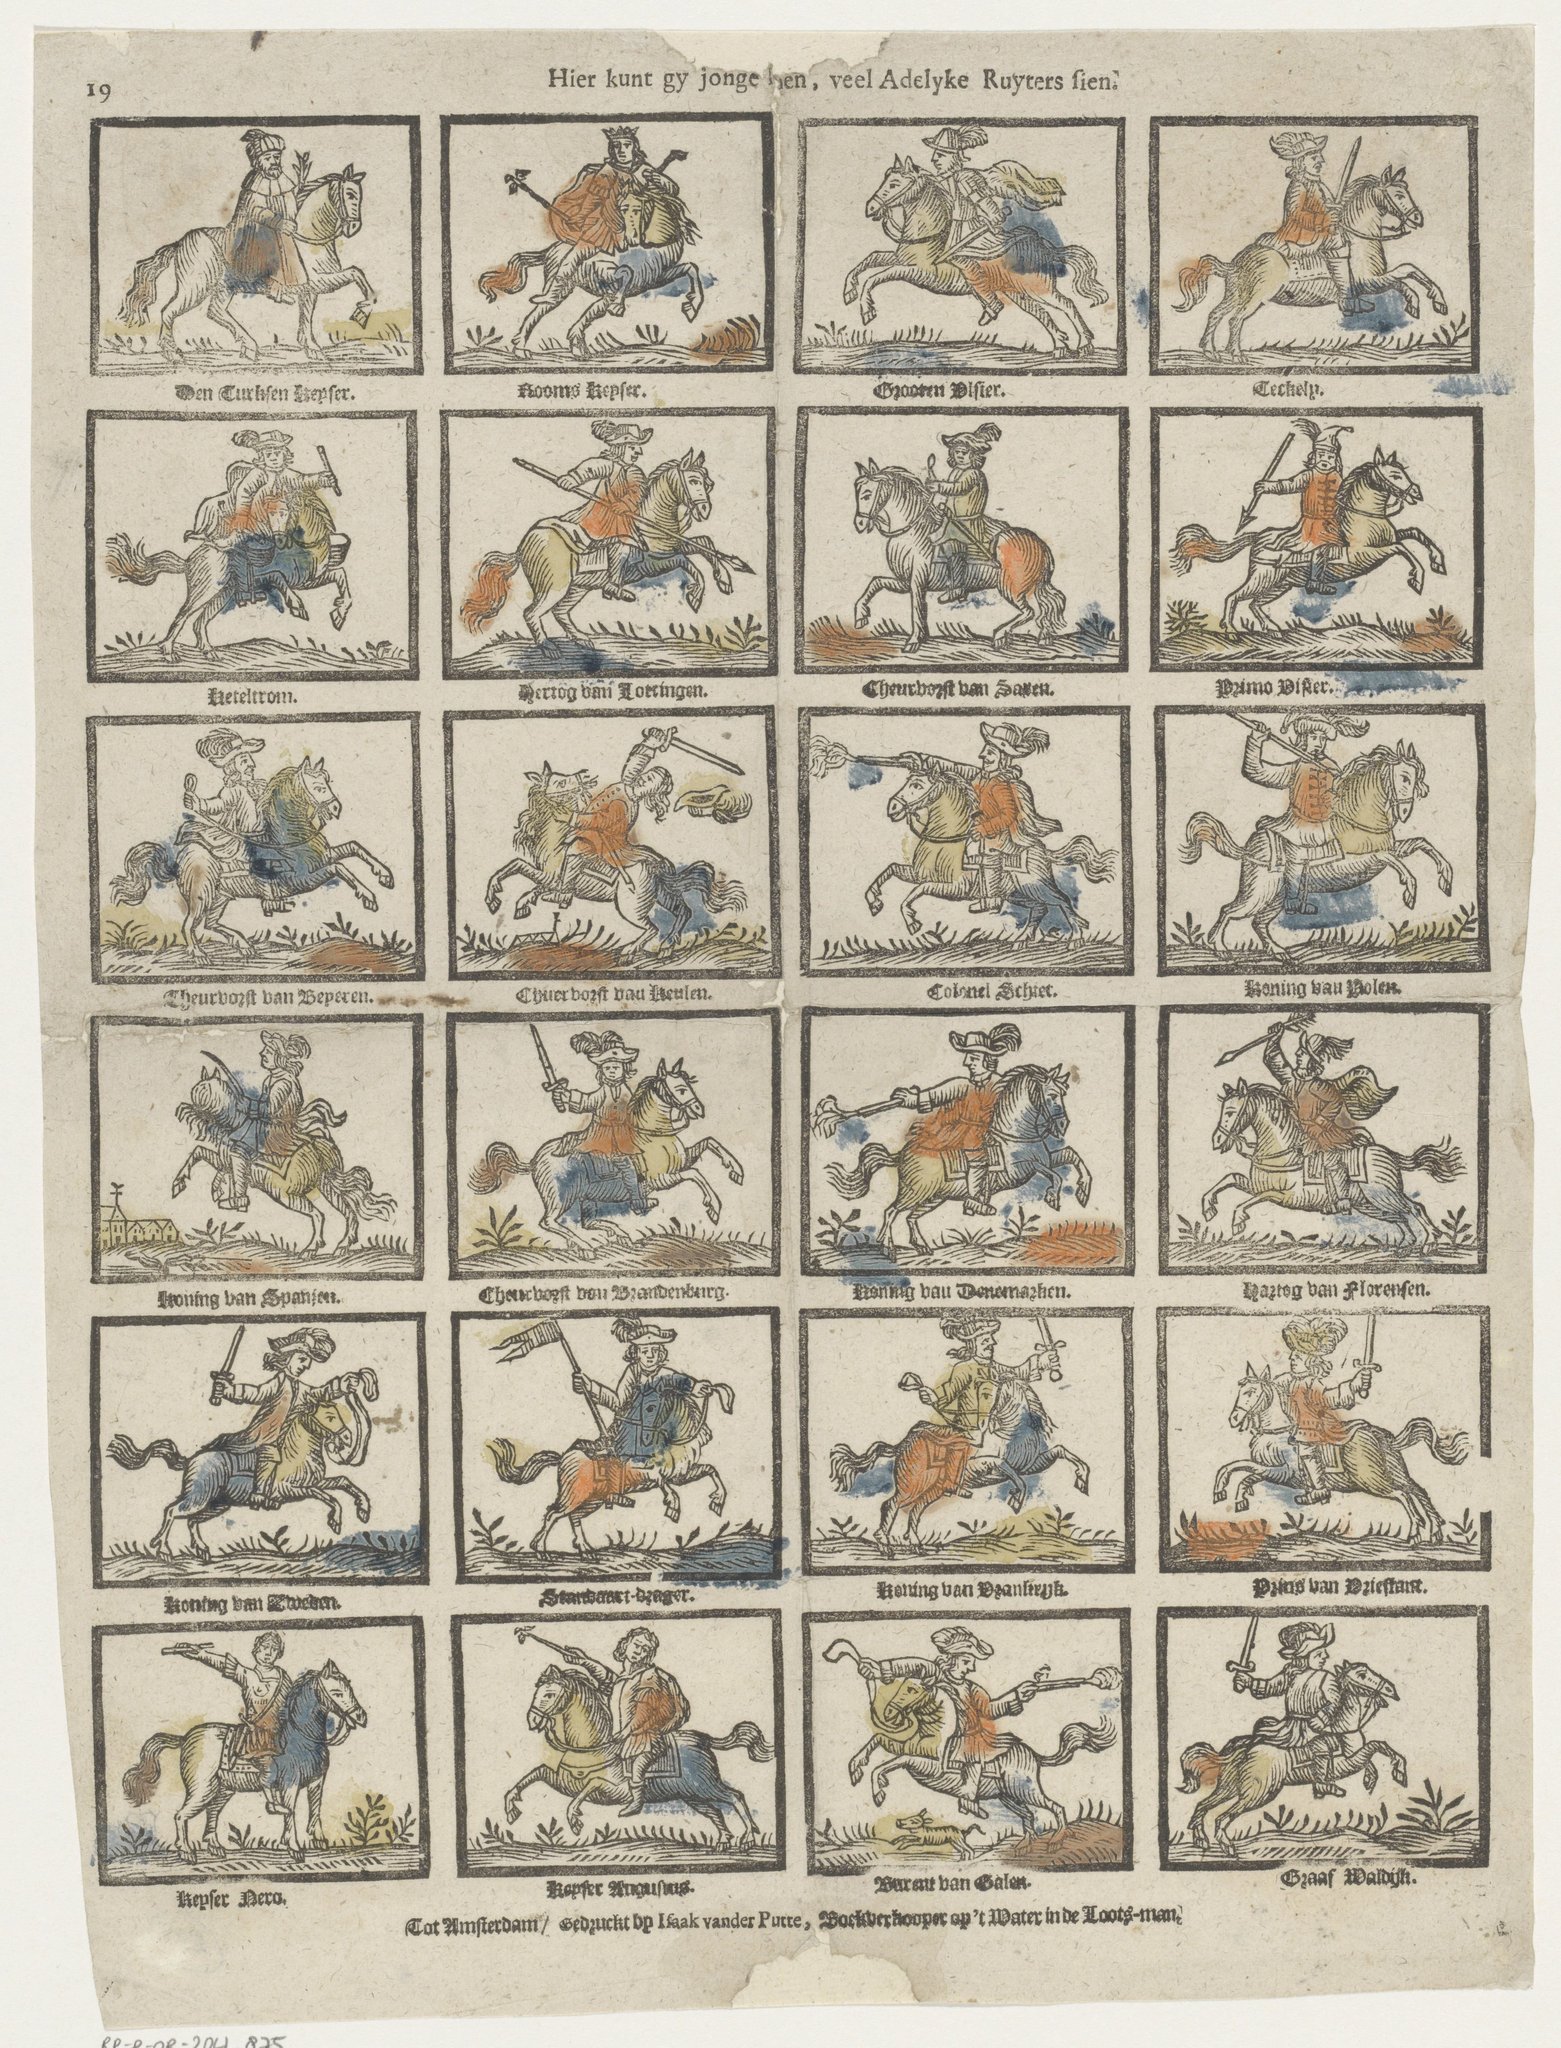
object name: print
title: Hier kunt gy jonge lien, veel adelyke ruyters sien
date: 1723-1748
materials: paper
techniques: colour, letterpress printing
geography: amsterdam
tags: riding a horse, ass, or mule; rider, horseman, ruler, sovereign, nobility and patriciate; chivalry, knighthood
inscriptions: collector's mark: Lugt 2760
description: Blad met 24 voorstellingen van edellieden te paard. Onder elke afbeelding een onderschrift. Genummerd linksboven: 19.